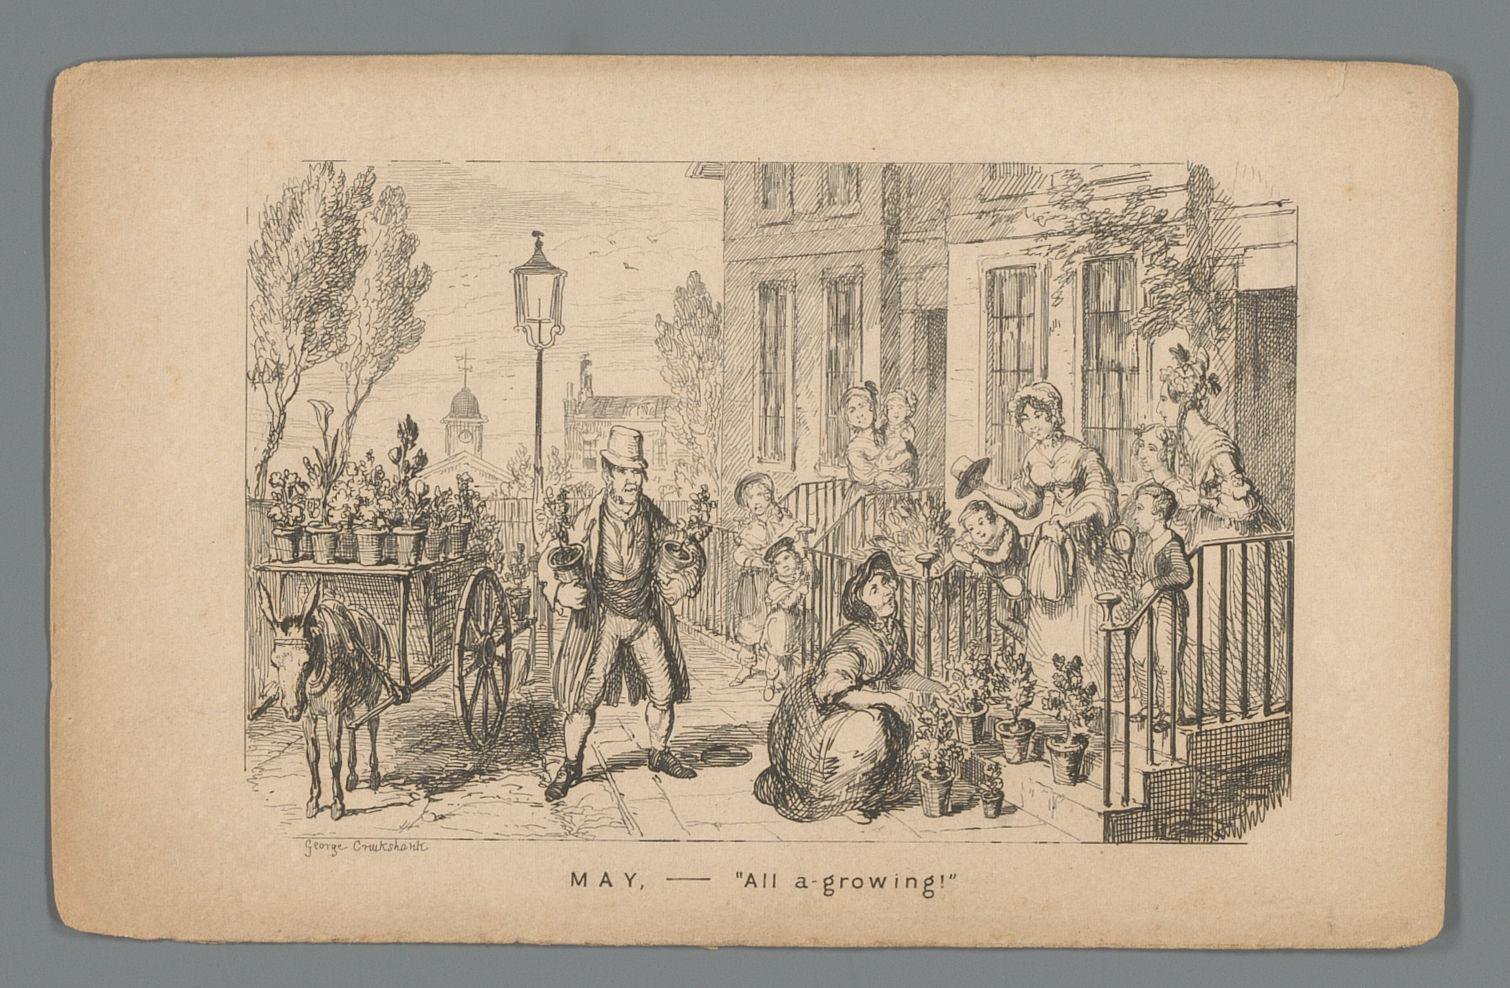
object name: book illustration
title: Mei: plantenverkopers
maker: george cruikshank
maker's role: painter, print maker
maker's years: 1792-1878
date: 1838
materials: paper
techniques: etching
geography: england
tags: street-trader - bb - women engaged in trade and commerce, may; 'maggio' (ripa), potted plants, political caricatures and satires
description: Man en vrouw verkopen potplanten vanuit een kar op straat. Illustratie voor de maand mei uit een uitgave van: The Comic Almanack (1838).